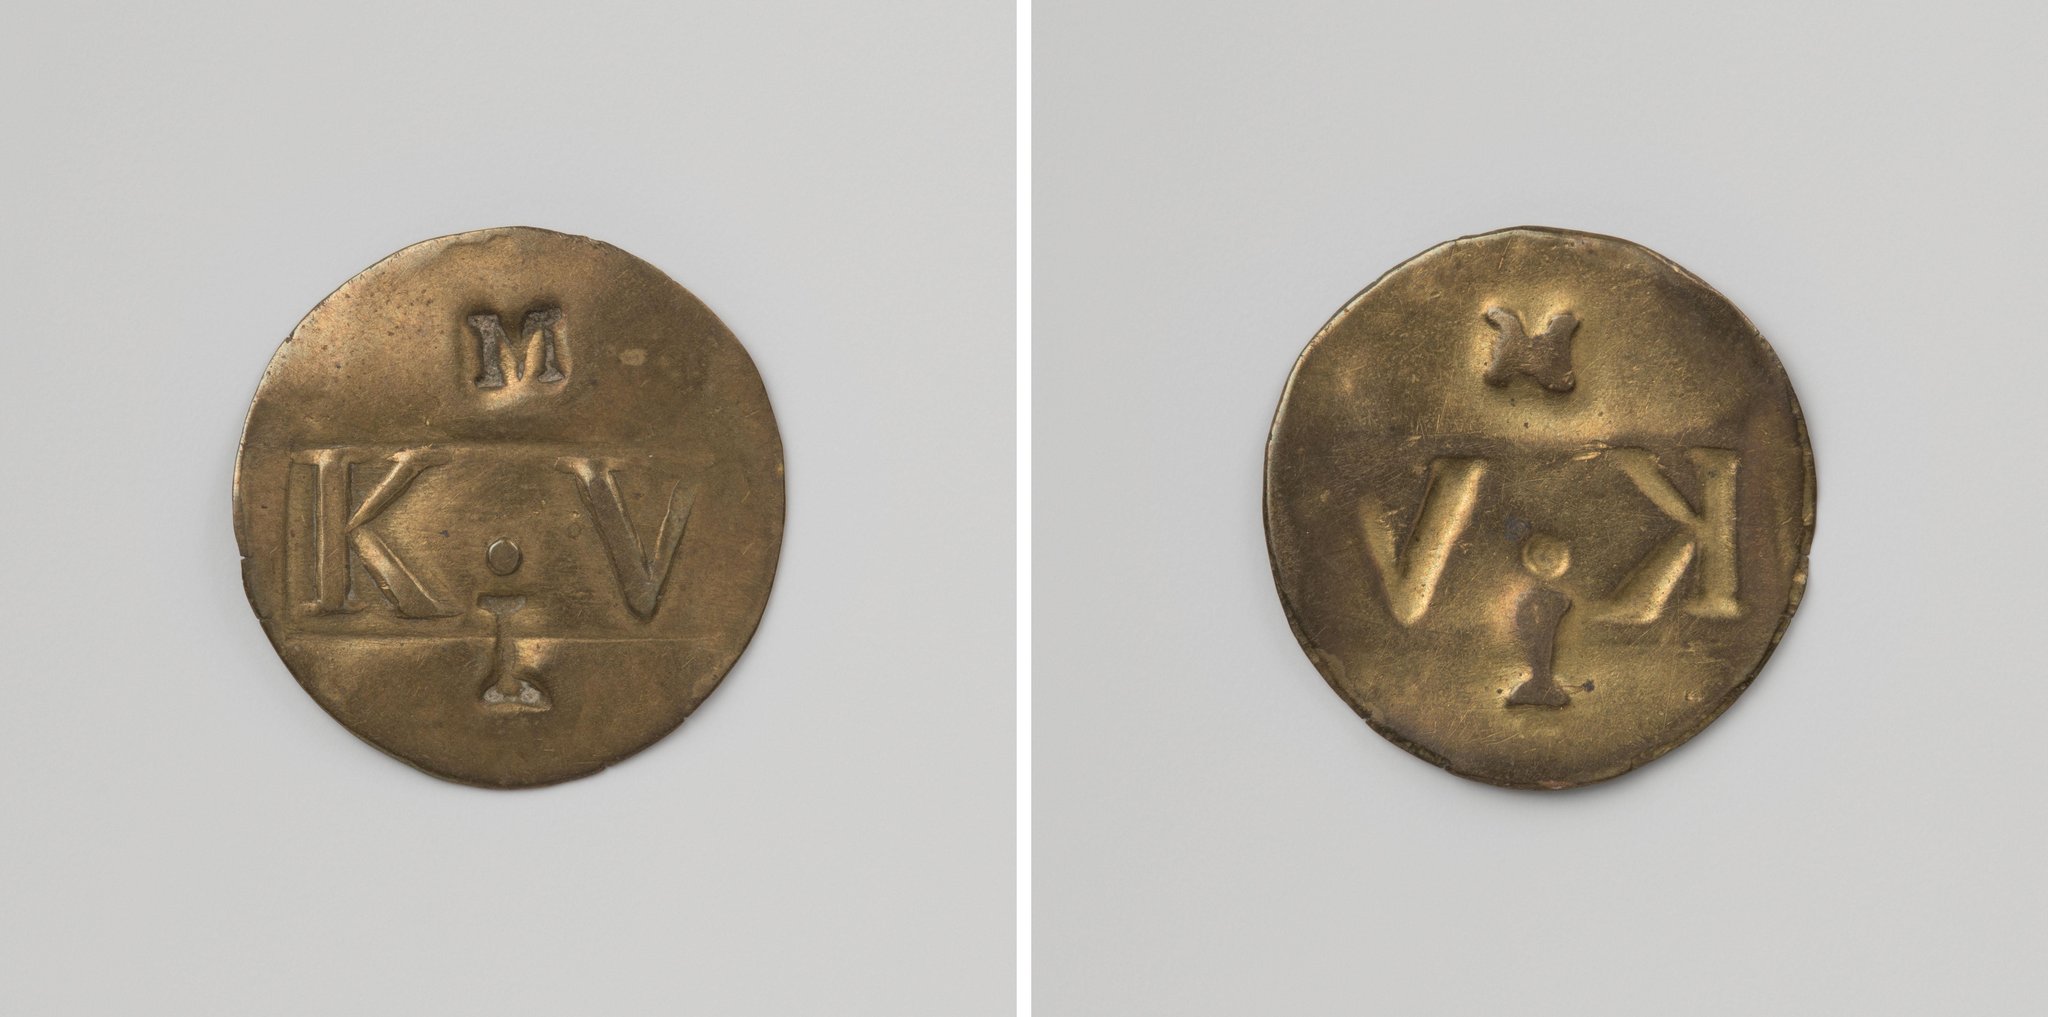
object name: monetary token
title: Kolonie Veenhuizen, huismunt geslagen op last van de Maatschappij van Weldadigheid ter waarde van 1 cent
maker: Anonymous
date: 1818-1859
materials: brass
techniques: striking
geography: netherlands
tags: maatschappij van weldadigheid, veenhuizen